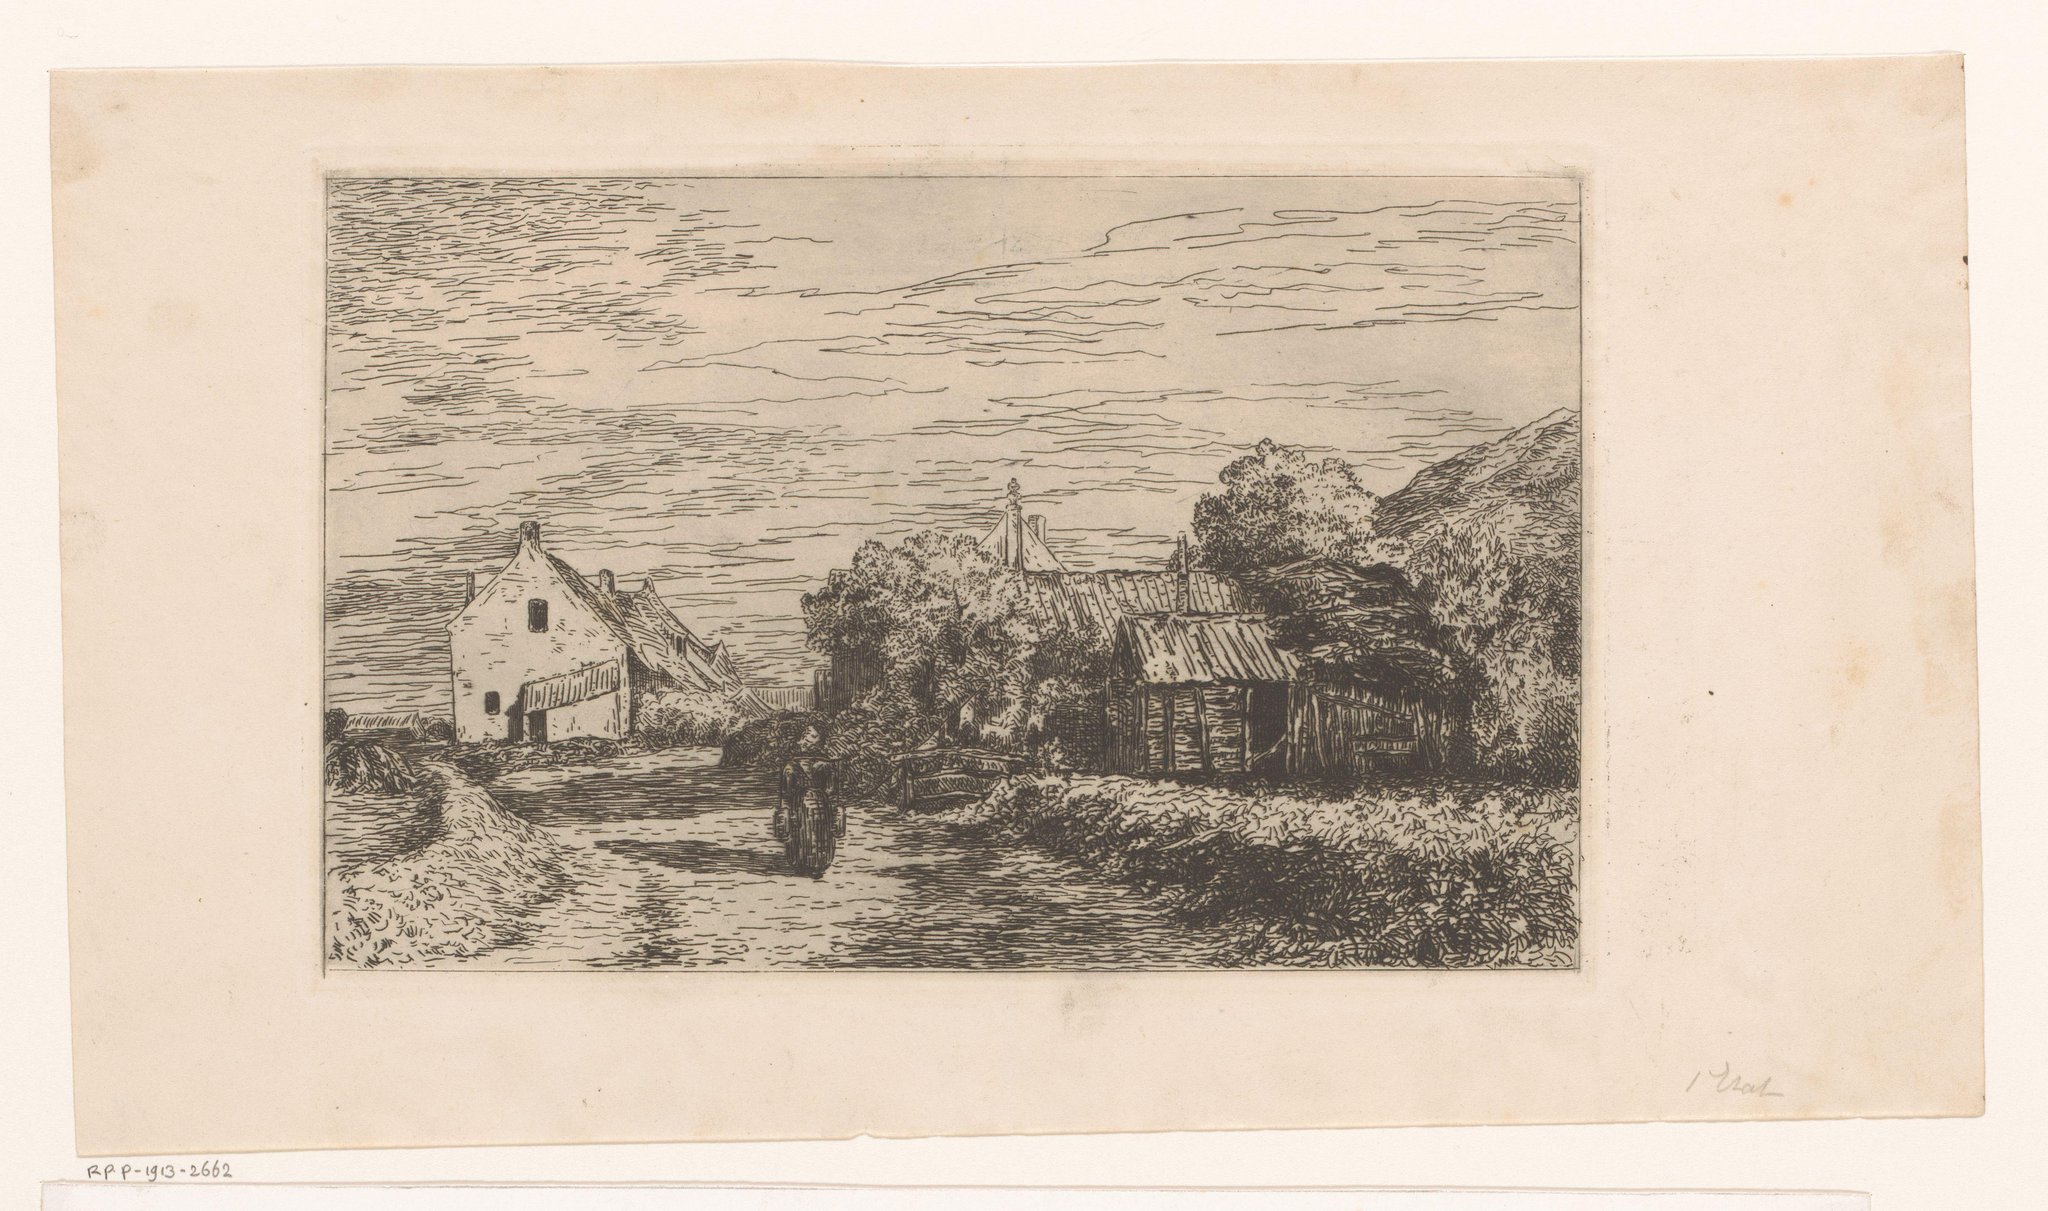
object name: print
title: Vrouw loopt met juk over een dorpsweg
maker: emilie rolin-jacquemijns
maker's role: print maker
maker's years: 1842-1906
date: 1852-1906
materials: paper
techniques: etching, retroussage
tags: carrying something with carrying-pole, adult woman, village street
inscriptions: collector's mark: Lugt 2228